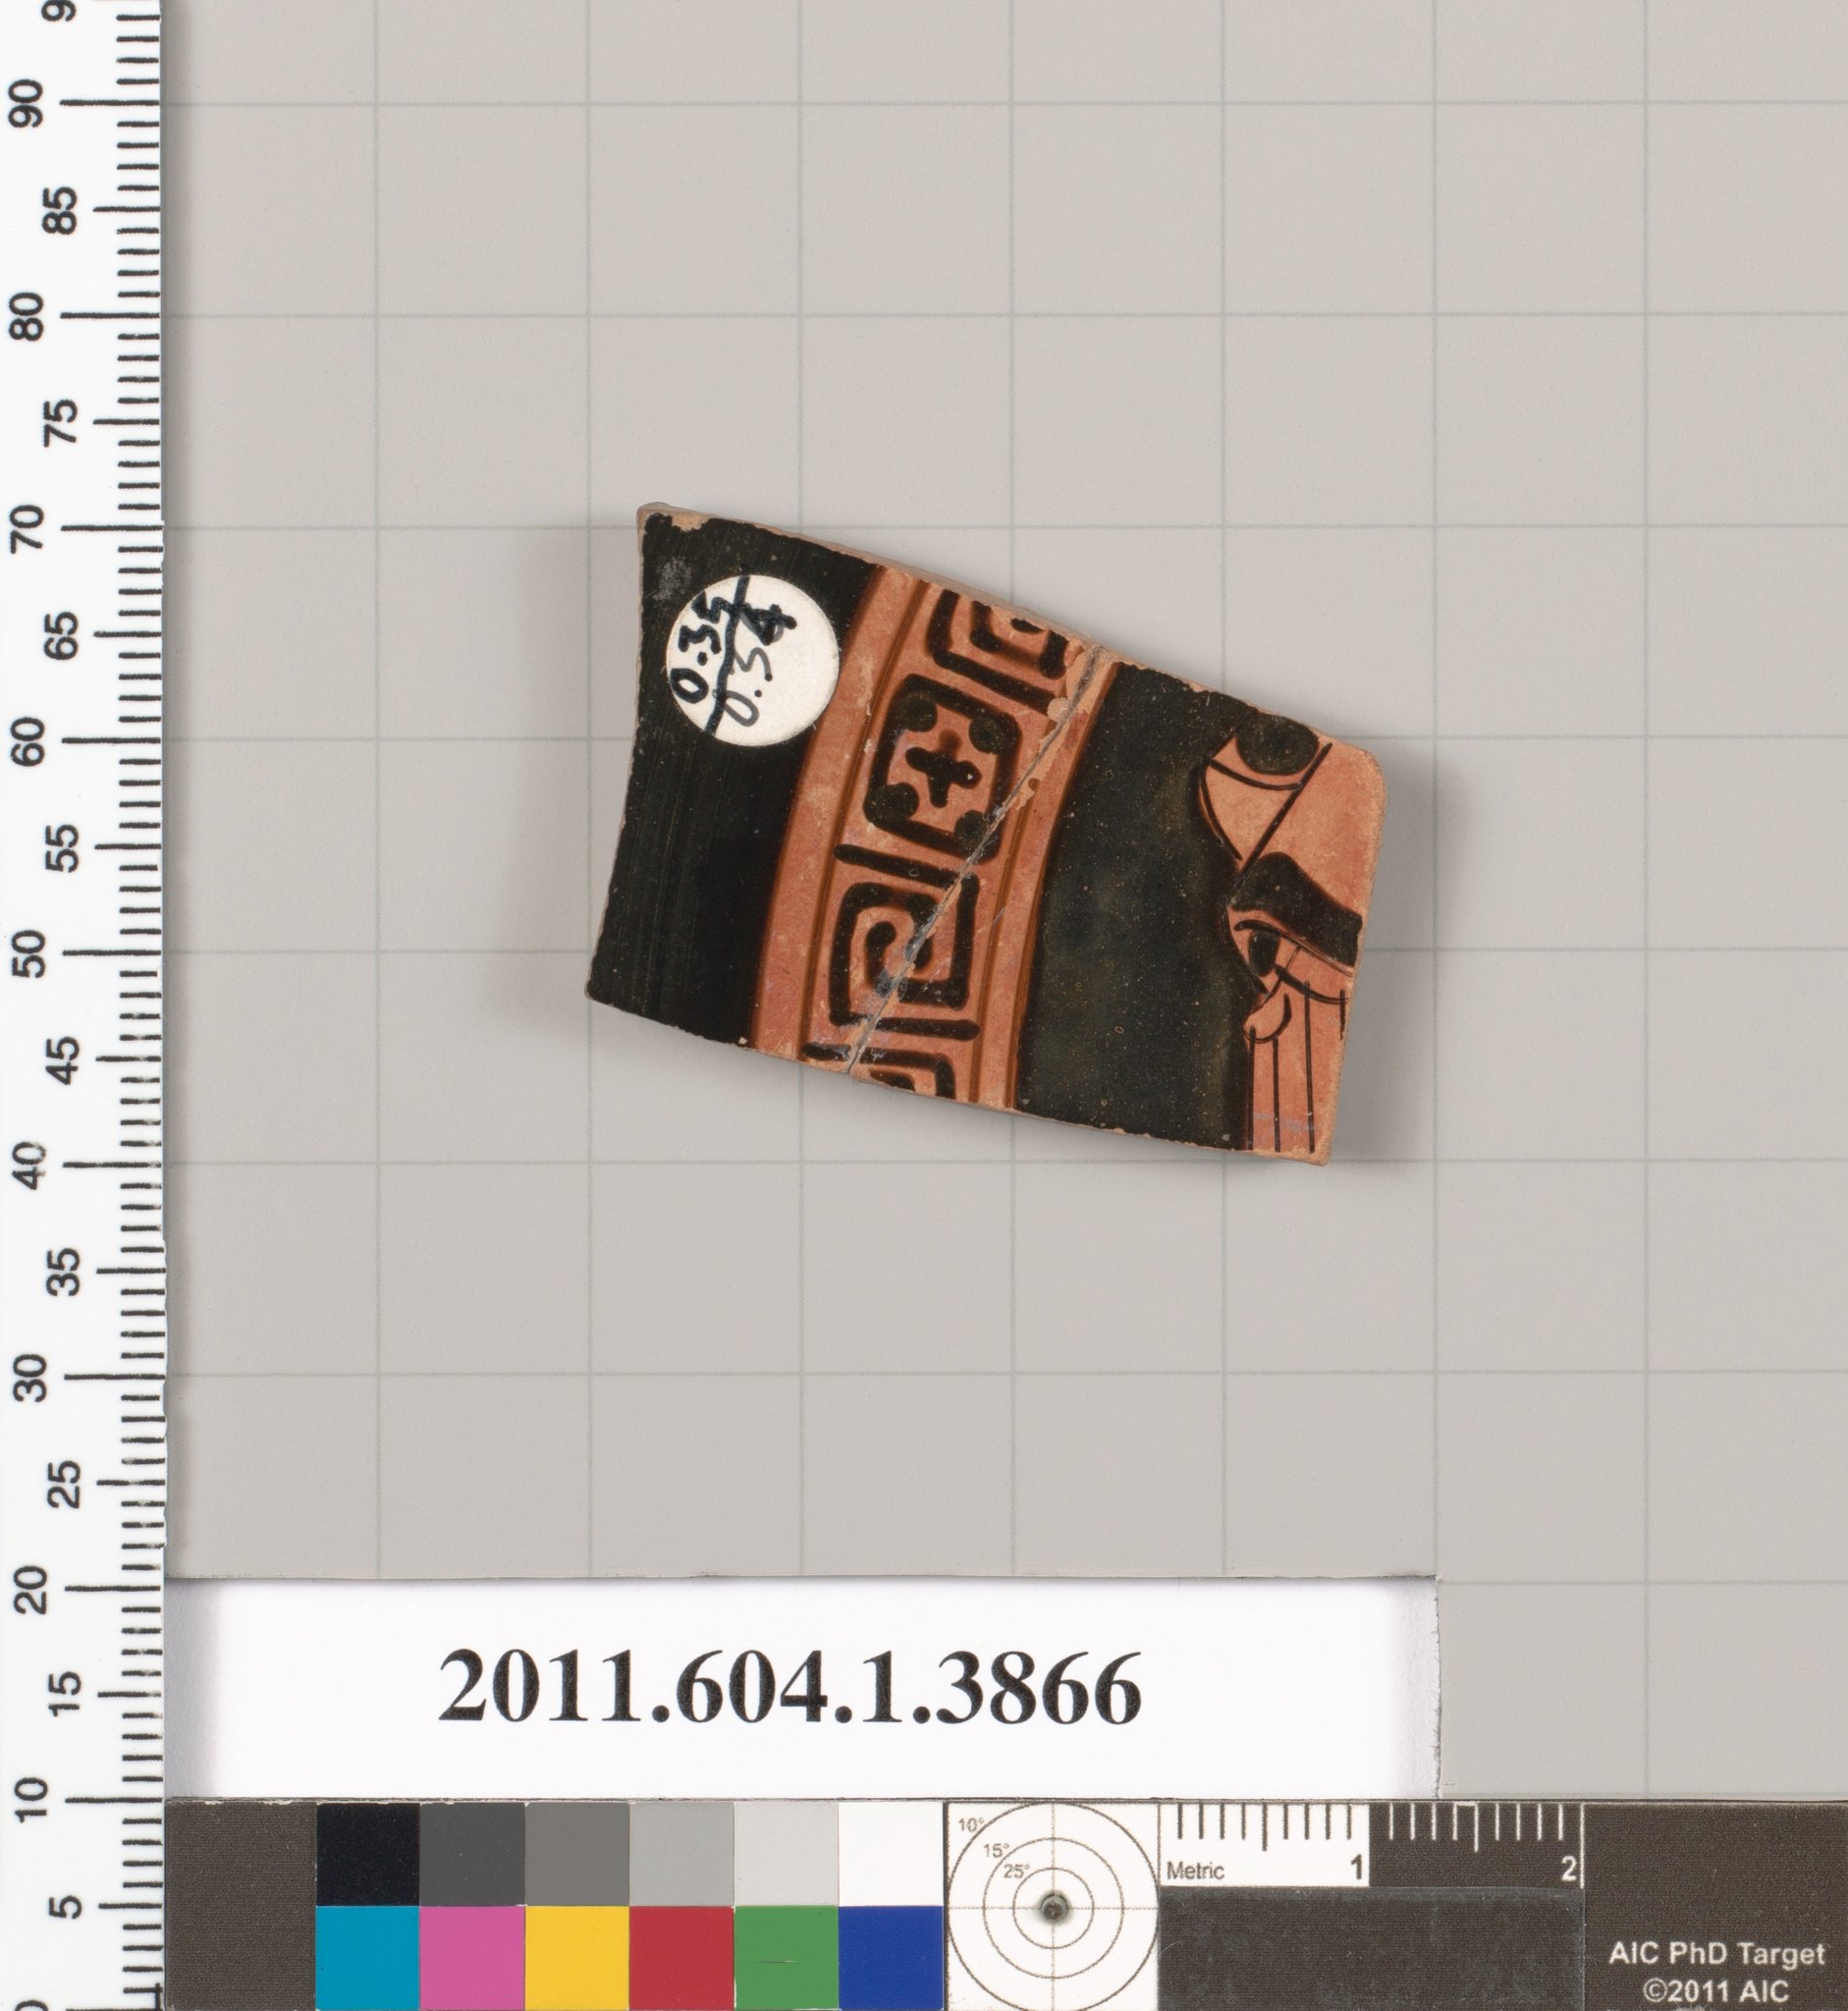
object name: kylix fragment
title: Terracotta fragment of a kylix (drinking cup)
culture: greek, attic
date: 475-451 BCE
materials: terracotta